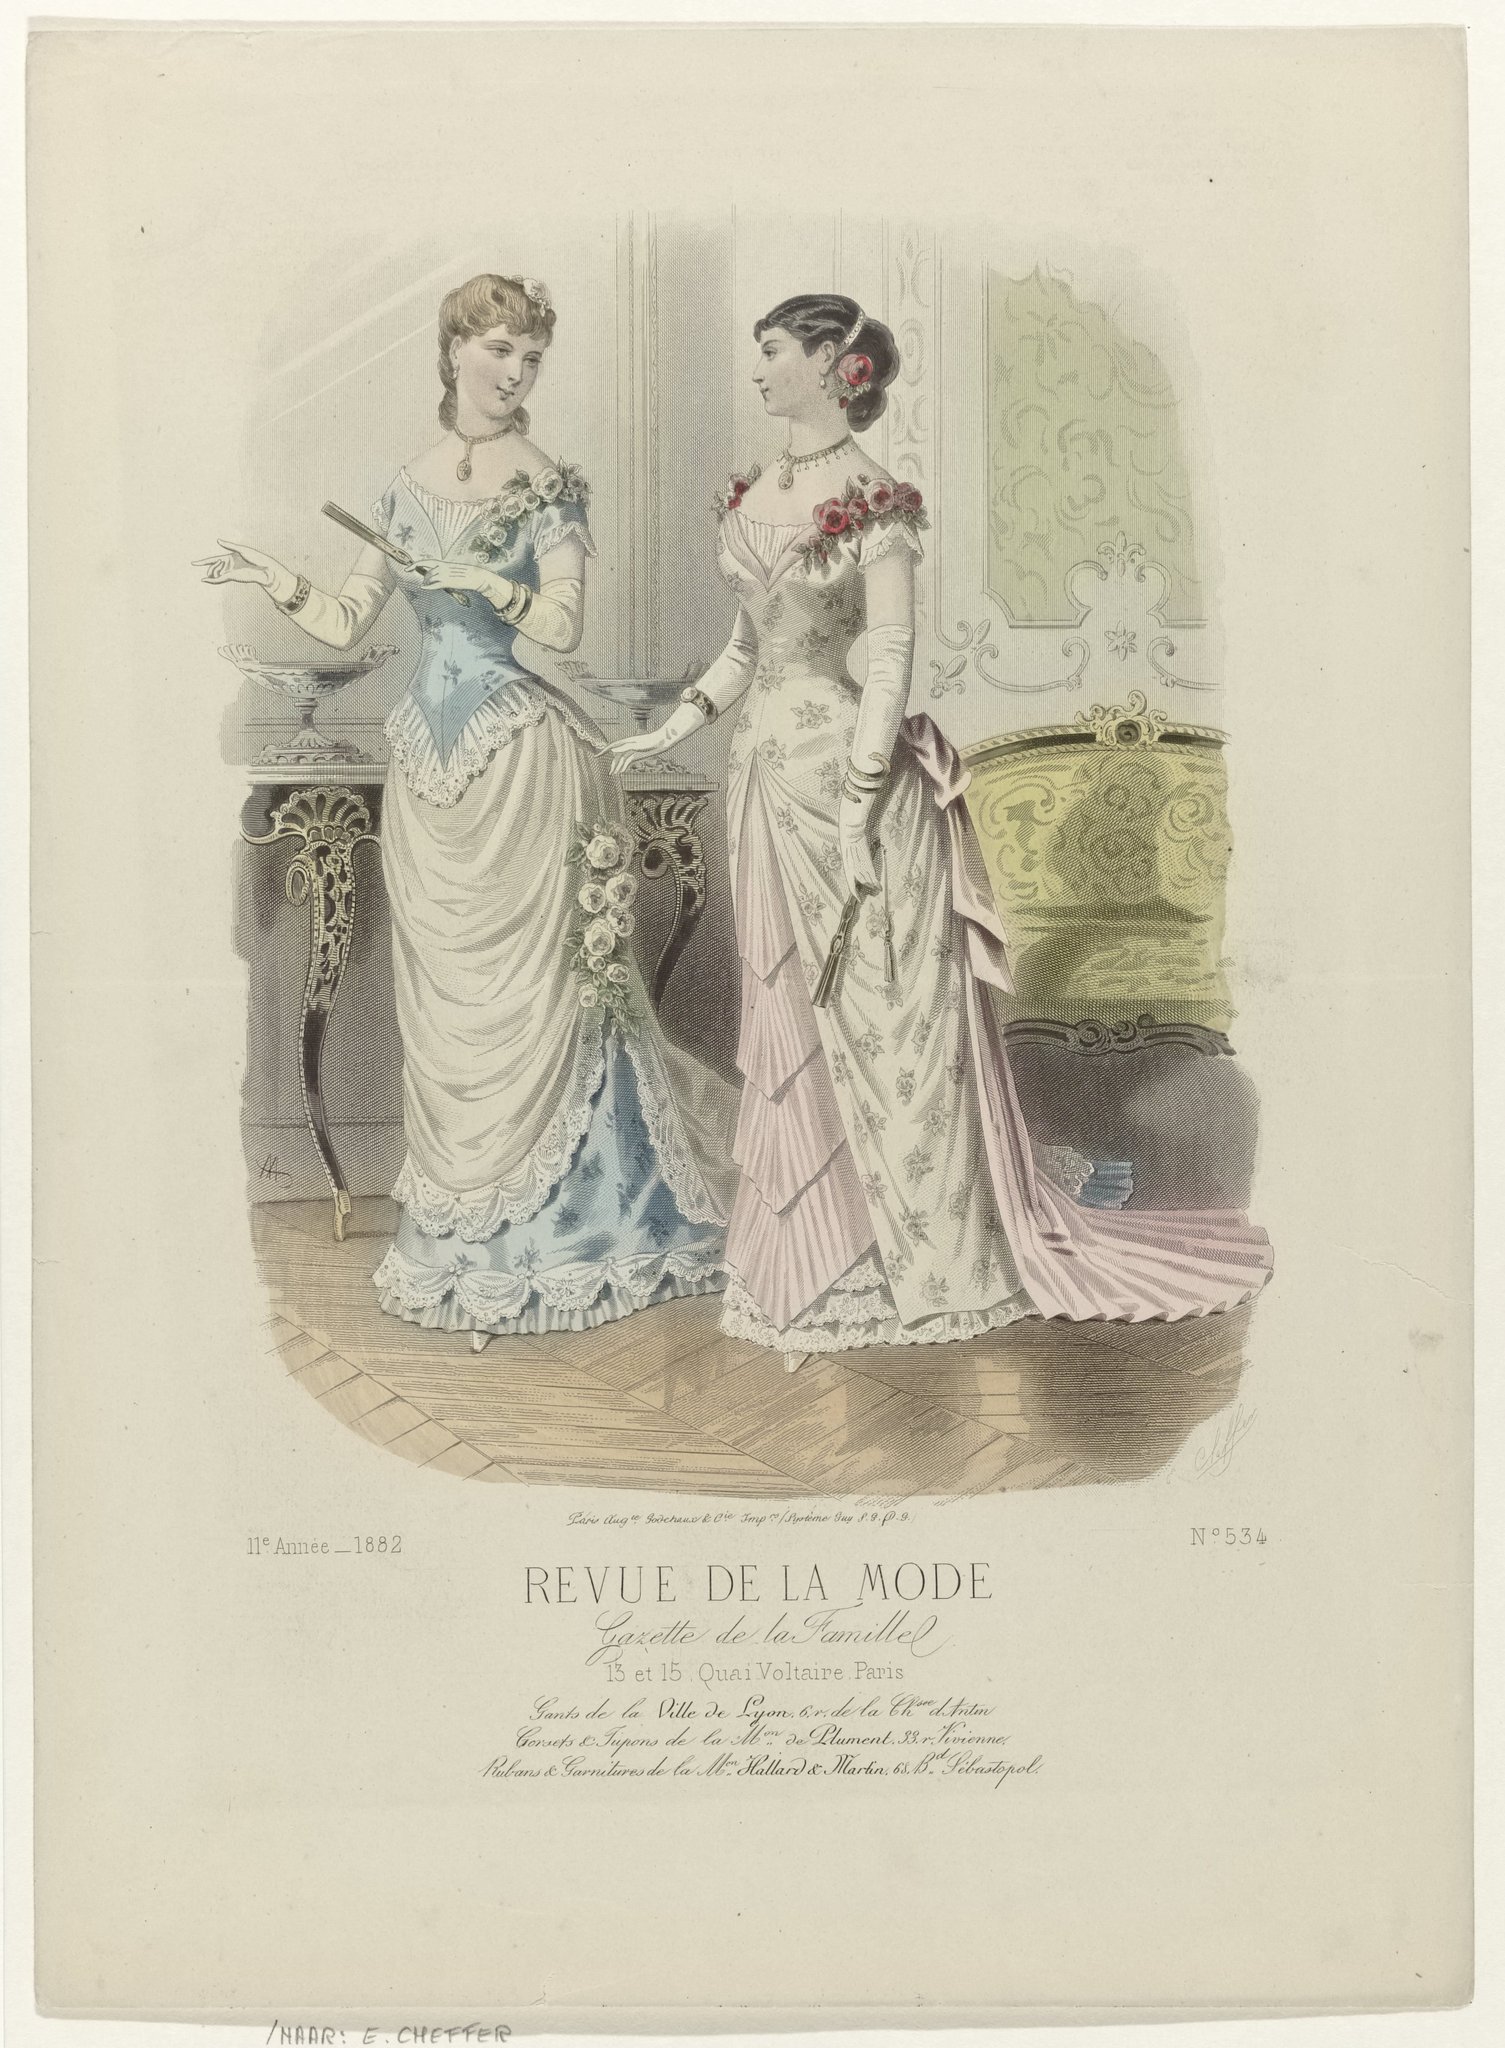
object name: fashion print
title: Revue de la Mode, Gazette de la Famille, dimanche 26 mars 1882, 11e année, No. 534: Gants de la Ville de Lyon (...)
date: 1882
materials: paper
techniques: engraving, hand coloring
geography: paris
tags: corsage (+ women's clothes), flowers, pendant, trinket, 'breloque' (+ women's clothes), diadem, tiara (+ women's clothes), gloves, mittens (long gloves) (+ women's clothes), dress, gown: ball gown (+ women's clothes), lace (+ women's clothes), fashion plates, fan (+ women's clothes), bracelet, wristlet (+ women's clothes)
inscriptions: caption: ‘Gants de la Ville de Lyon, 6, r. de la Ch.sée d'Antin. Corsets & Jupons de la M.on de Plument, 33, r. Vivienne. Rubans & Garnitures de la M.on Hallard & Martin, 68, B.d Sébastopol.’, address: ‘13 & 15, Quai Voltaire, Paris’, title: ‘REVUE DE LA MODE / Gazette de la Famille’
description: Twee vrouwen in een interieur. Links: baljapon van hemelsblauwe 'satin merveilleux' (satijn) en brocatel, gegarneerd met kant. Rechts: baljapon van roze 'surah' en brocatel 'Pompadour' en/of bedrukte moiré. De lange handschoenen komen uit Lyon. Onder de afbeelding enkele regels reclametekst voor verschillende producten. Prent uit het modetijdschrift Revue de la Mode (1872-1913). Uitgebreide beschrijving van de kleding op pagina 110 "PLANCHE COLORIÉE".